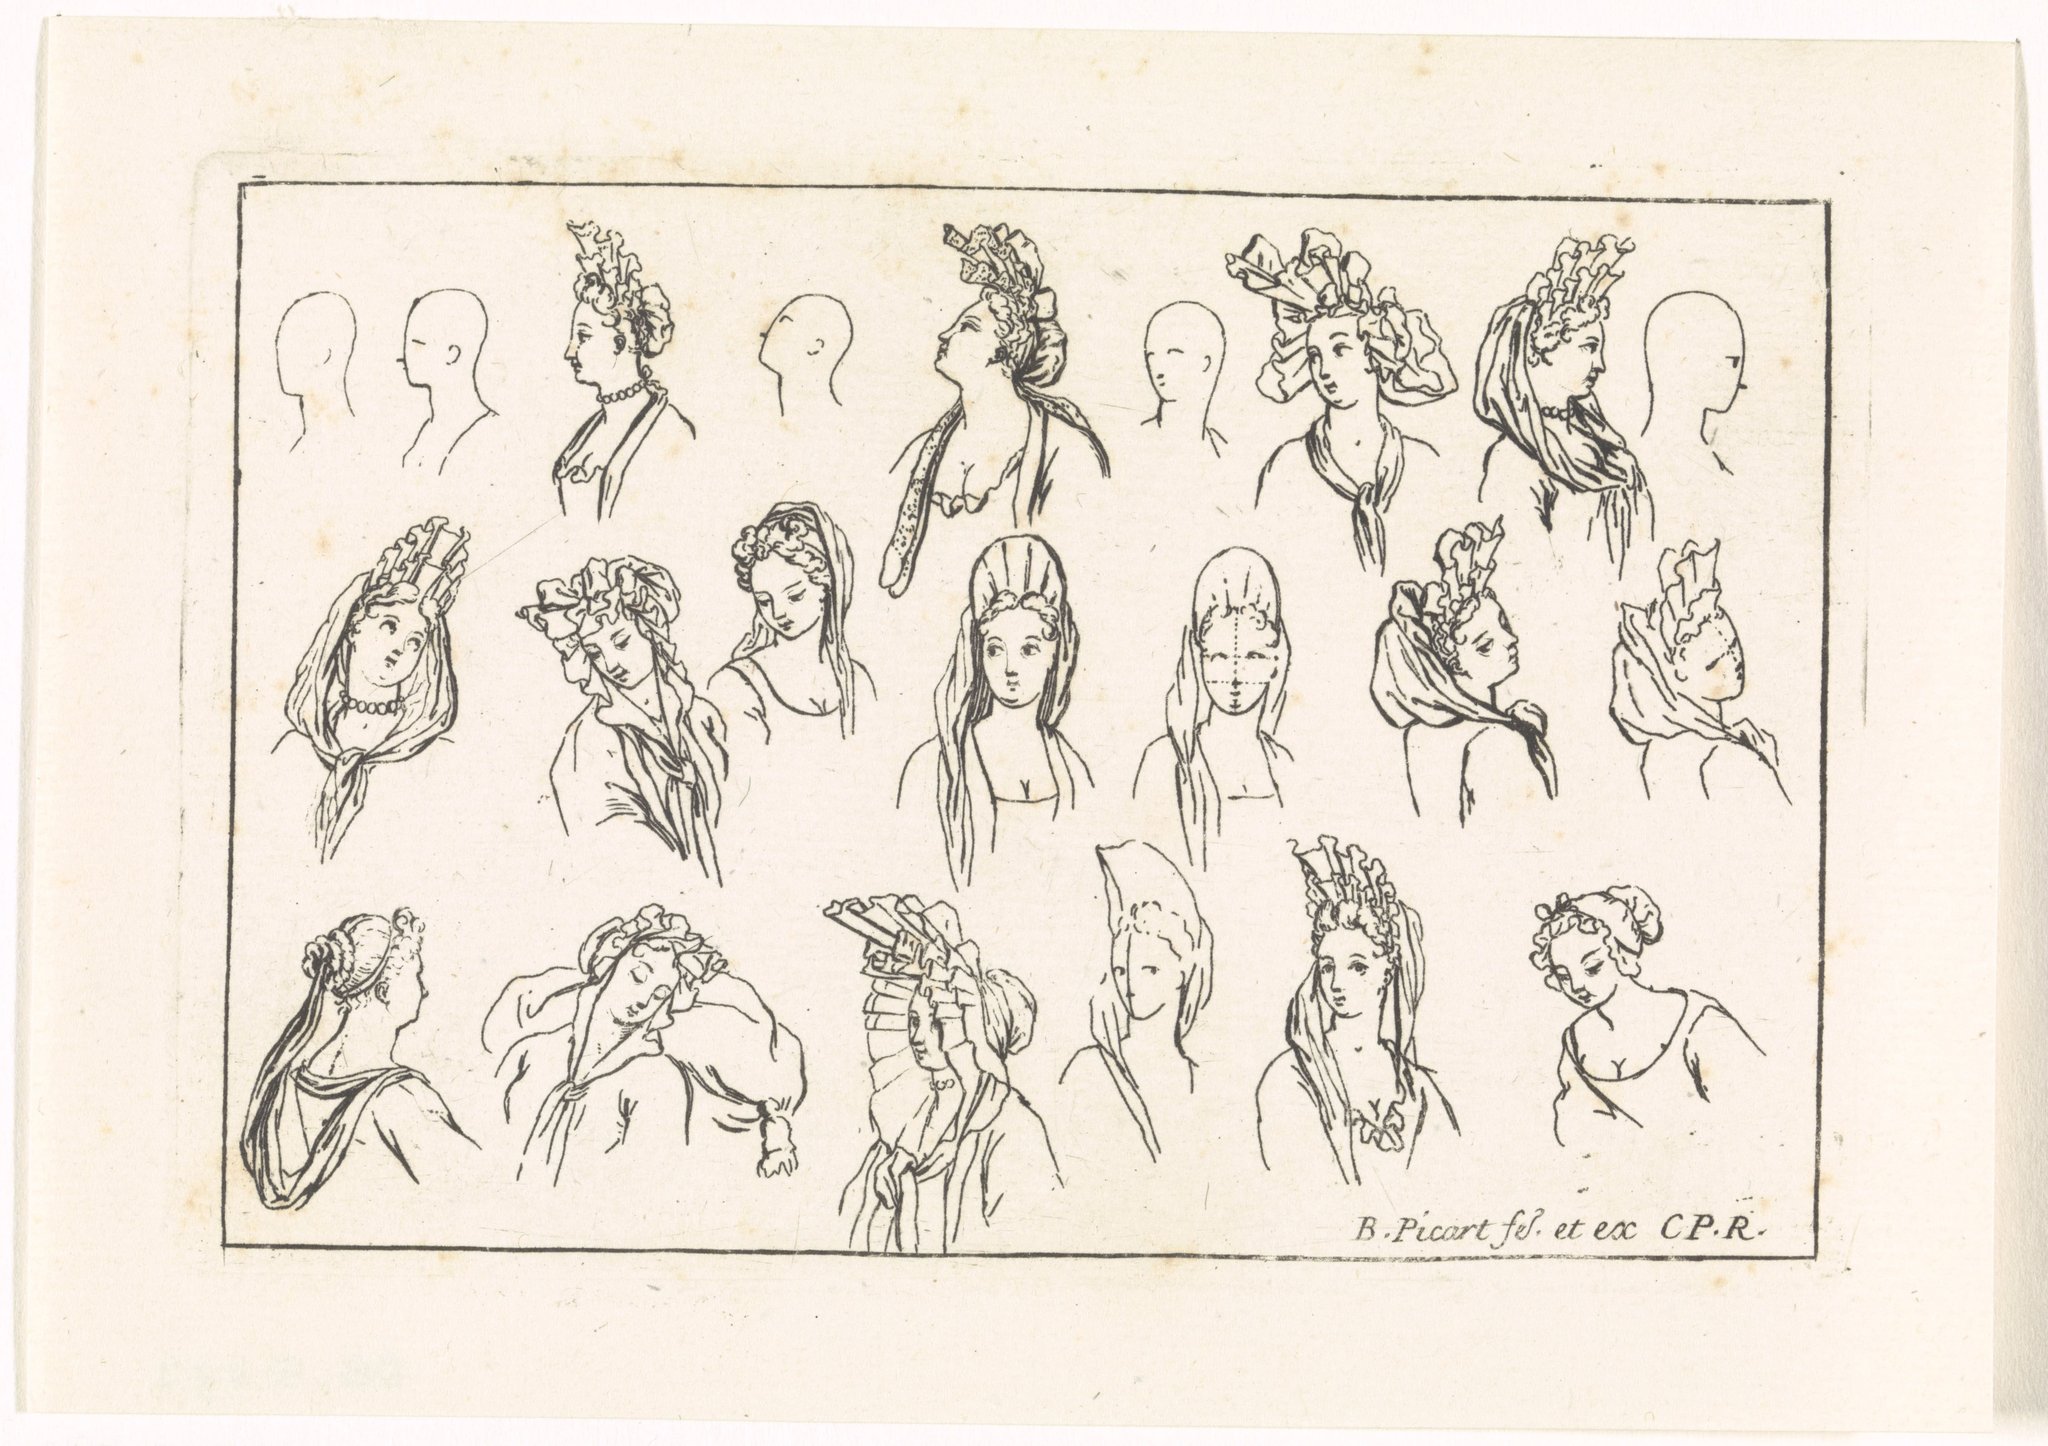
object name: print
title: Studiebladen met modeverschijnselen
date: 1703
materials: paper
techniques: etching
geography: paris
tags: head-gear: hat (+ women's clothes), wig, fashion